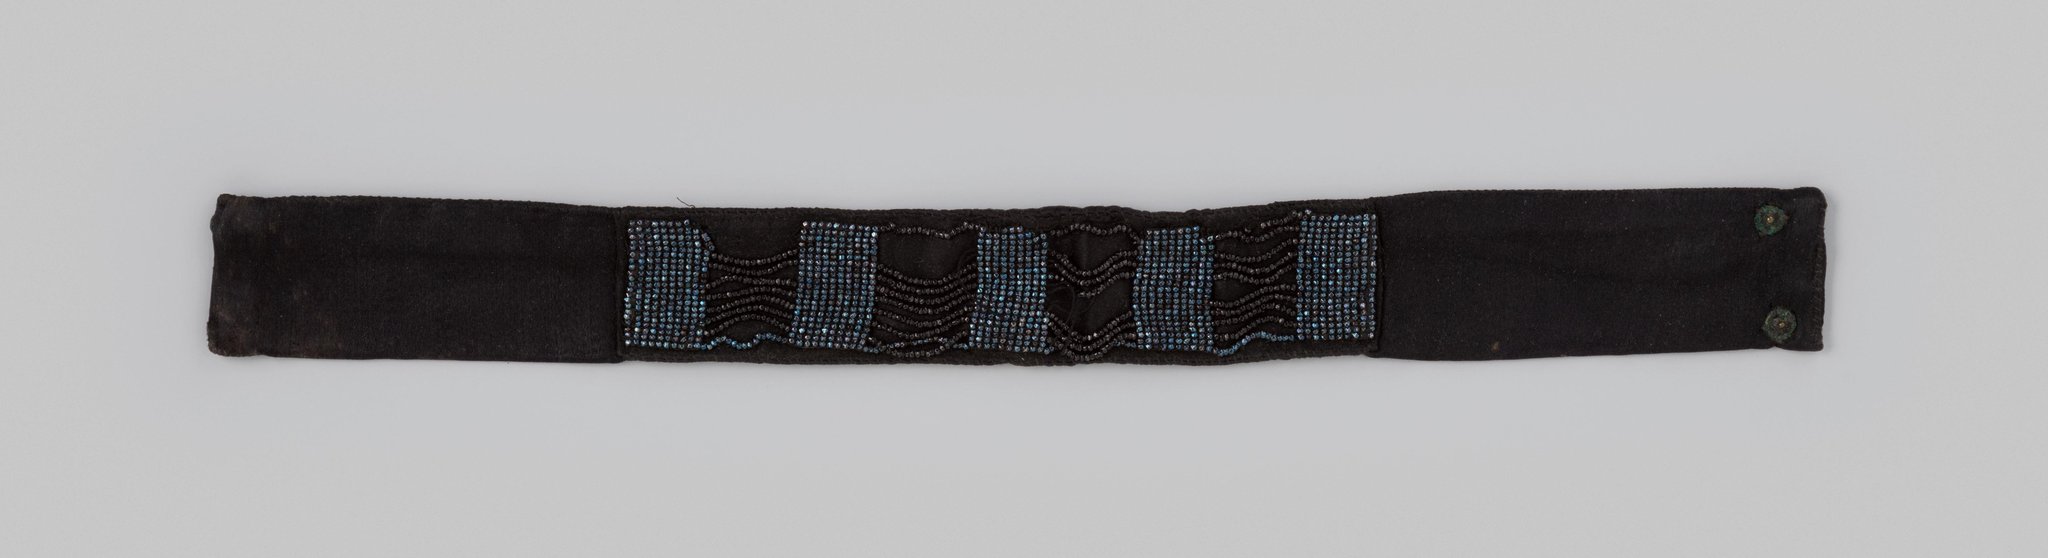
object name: halsband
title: Halsband van zwart satijn versierd met kralen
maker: Anonymous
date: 1900-1915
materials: glass, textile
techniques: sewing, weave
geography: netherlands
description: Halsband van zwart satijn versierd met kralen. Tussen vijf rechthoeken van iriserende blauwe kralen lopen horizontale strengen zwarte kralen. De sluiting bestaat uit drukknopen.